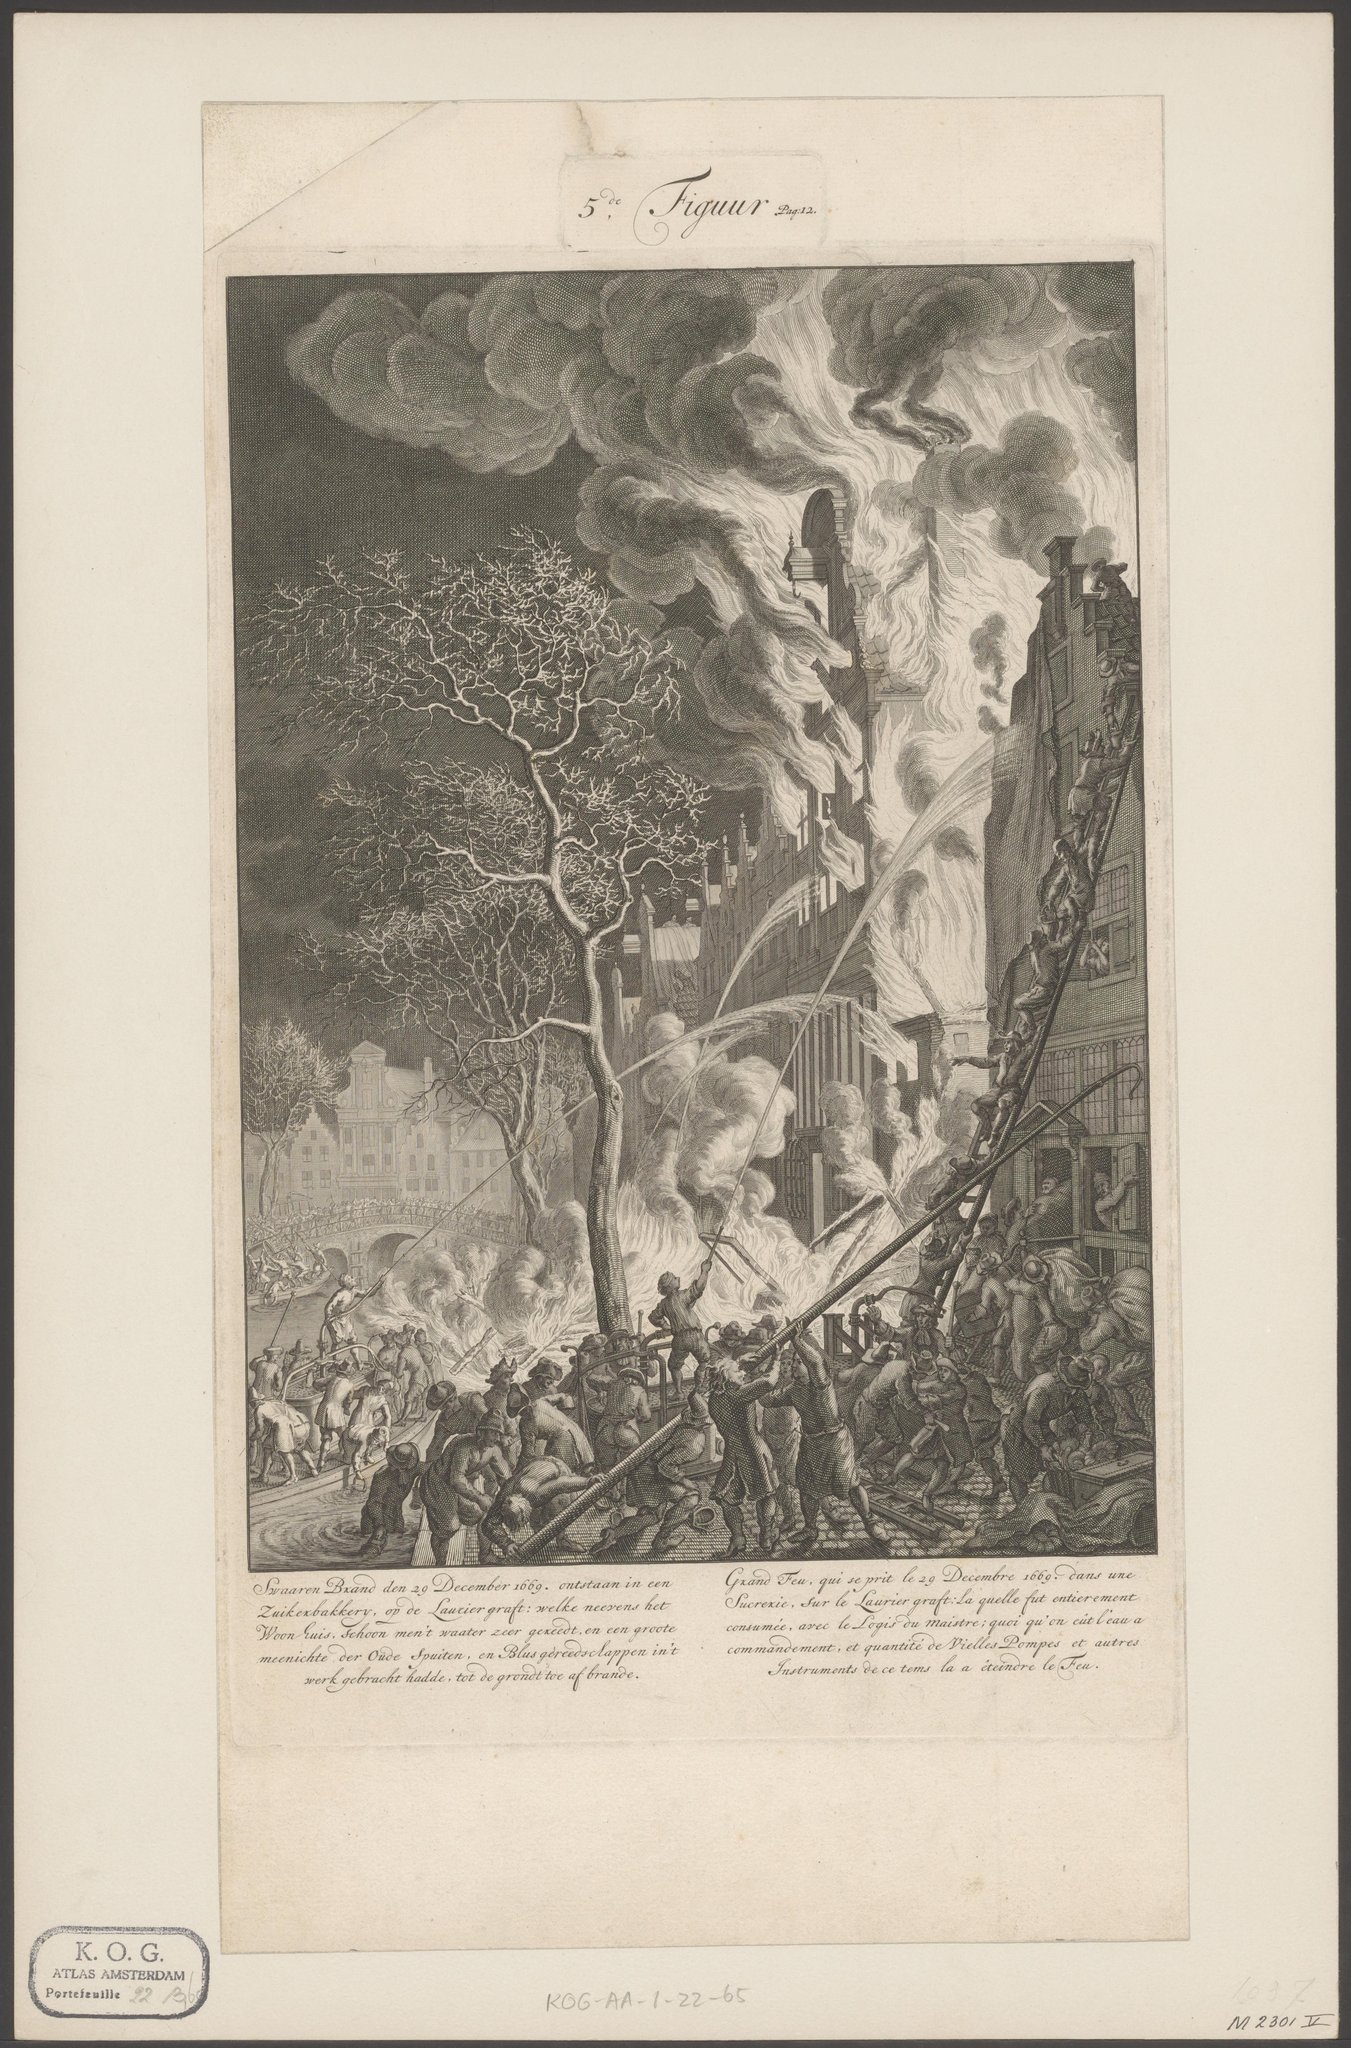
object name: print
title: Swaaren Brand den 29 December 1669. ontstaan in een Zuikerbakkery, op de Lauriergraft (...) / Grand feu, qui se prit le 29 Decembre 1669. dans une Sucrerie, sur le Lauriergraft (...)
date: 1690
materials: paper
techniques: engraving, etching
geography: amsterdam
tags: painter, print maker, draughtsman, jan van der heyden, on fire, ablaze, fire-fighting, fire-extinguishing equipment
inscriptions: collector's mark: Lugt 1641b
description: Brand in een suikerbakkerij aan de Lauriergracht te Amsterdam op 29 december 1669. De brand wordt bestreden met oude brandspuiten en water uit de gracht. Desondanks brandde het pand geheel af. Rechts wordt huisraad uit een belendend pand gehaald. Vijf regels onderschrift in het Nederlands en het Frans. Centraal bovenaan: 5de Figuur. Pag: 12. Onderwerpsrubriek binnen de Atlas Amsterdam: Gemeentewerken: B. Branden in particuliere gebouwen.